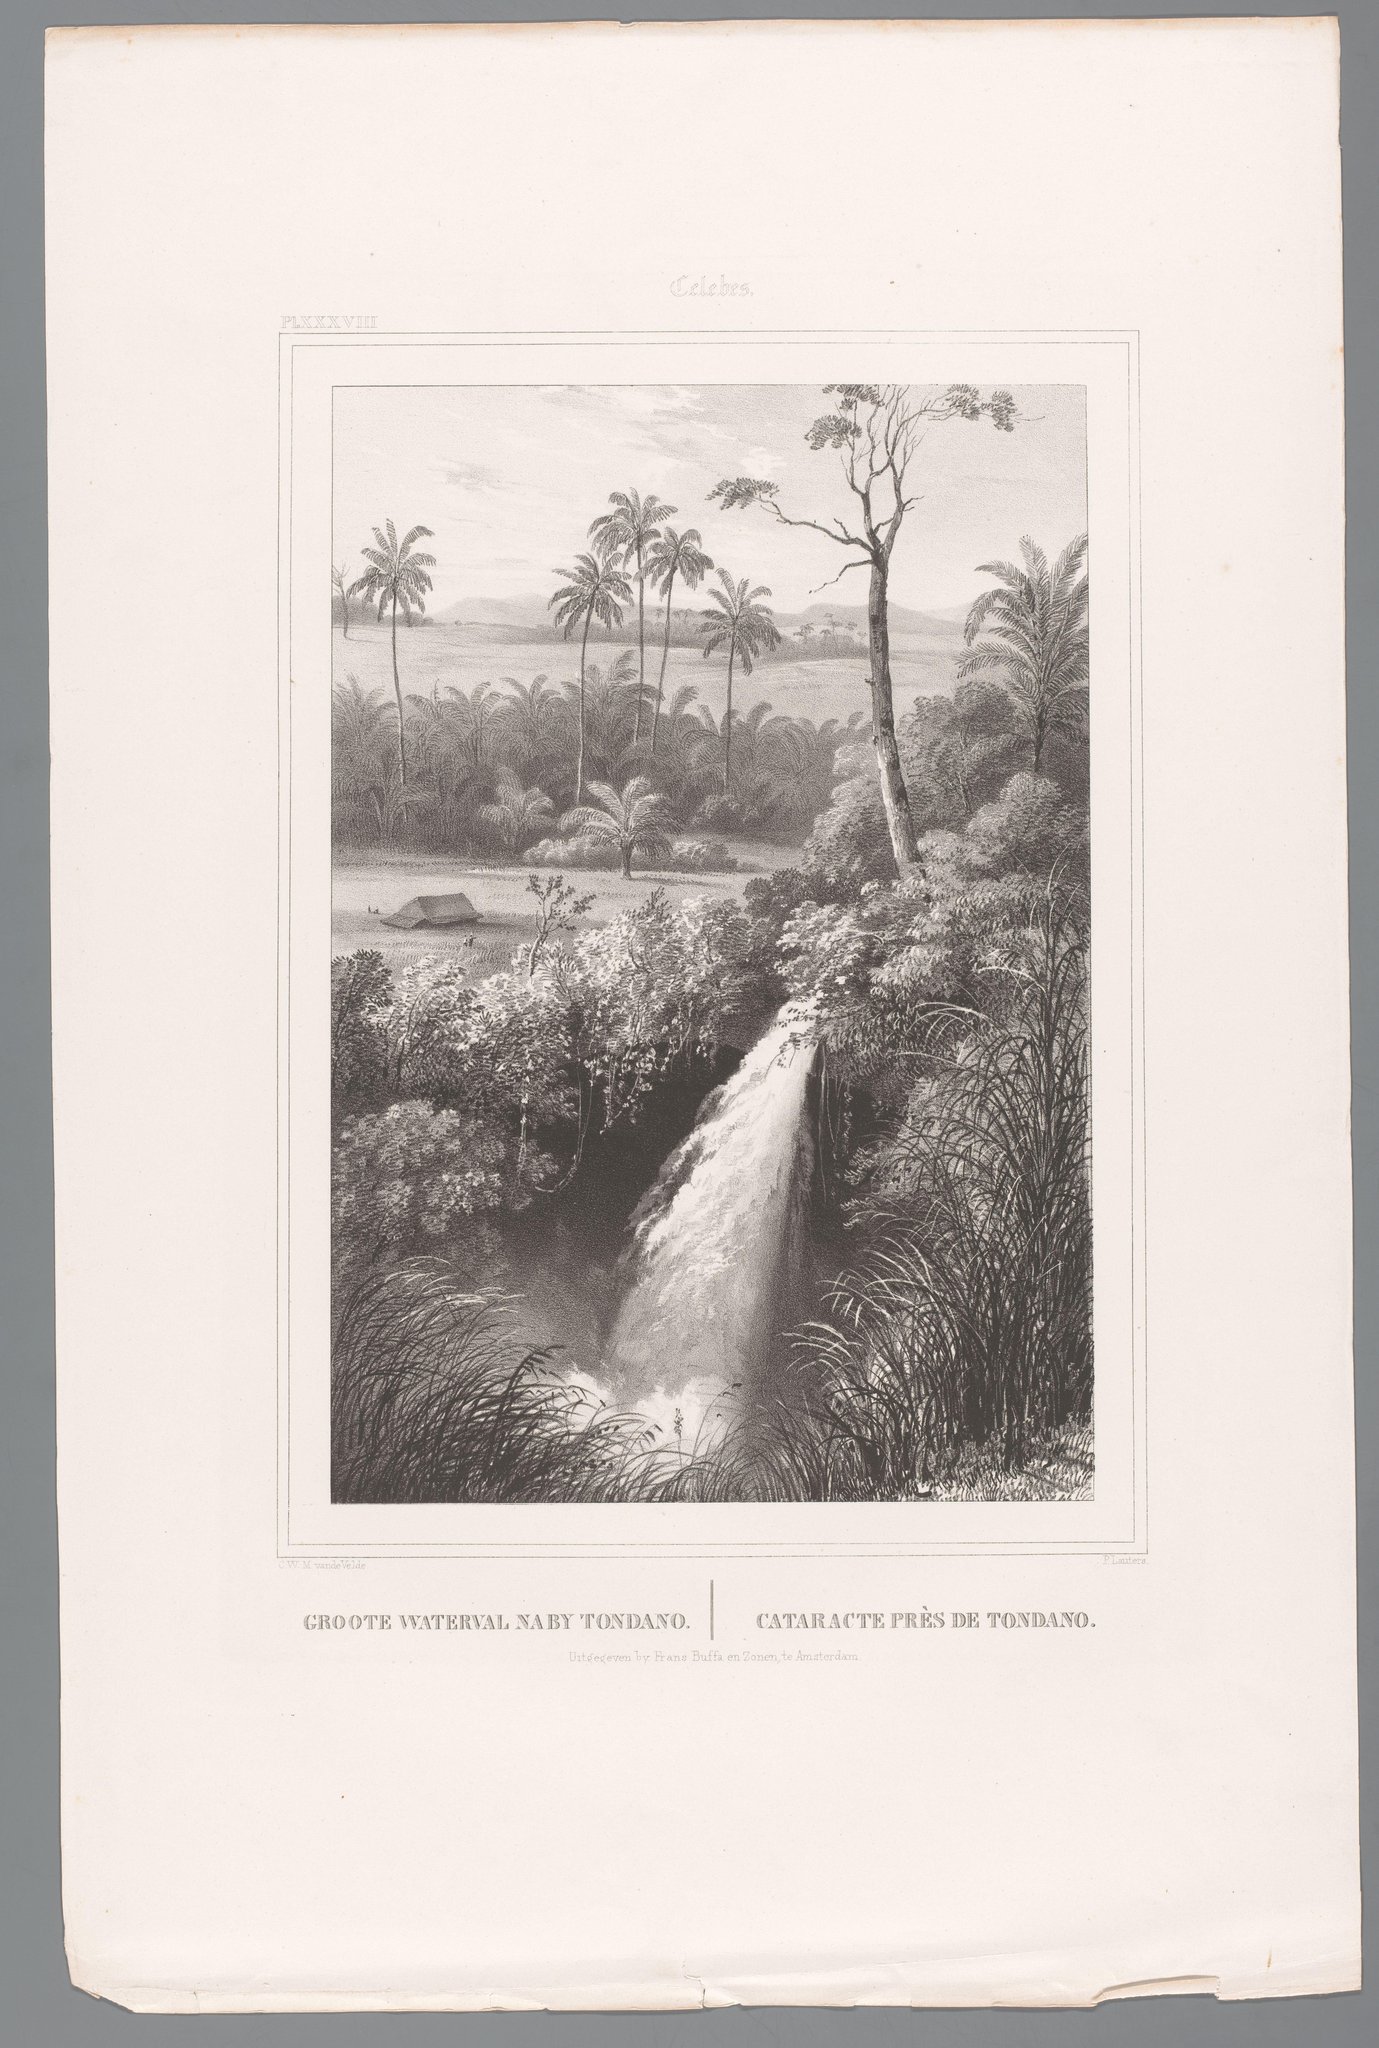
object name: print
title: Waterval bij Tondano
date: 1847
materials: paper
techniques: lithograph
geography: amsterdam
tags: waterfall, landscapes in the non-temperate zone, exotic landscapes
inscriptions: collector's mark: Lugt 2228